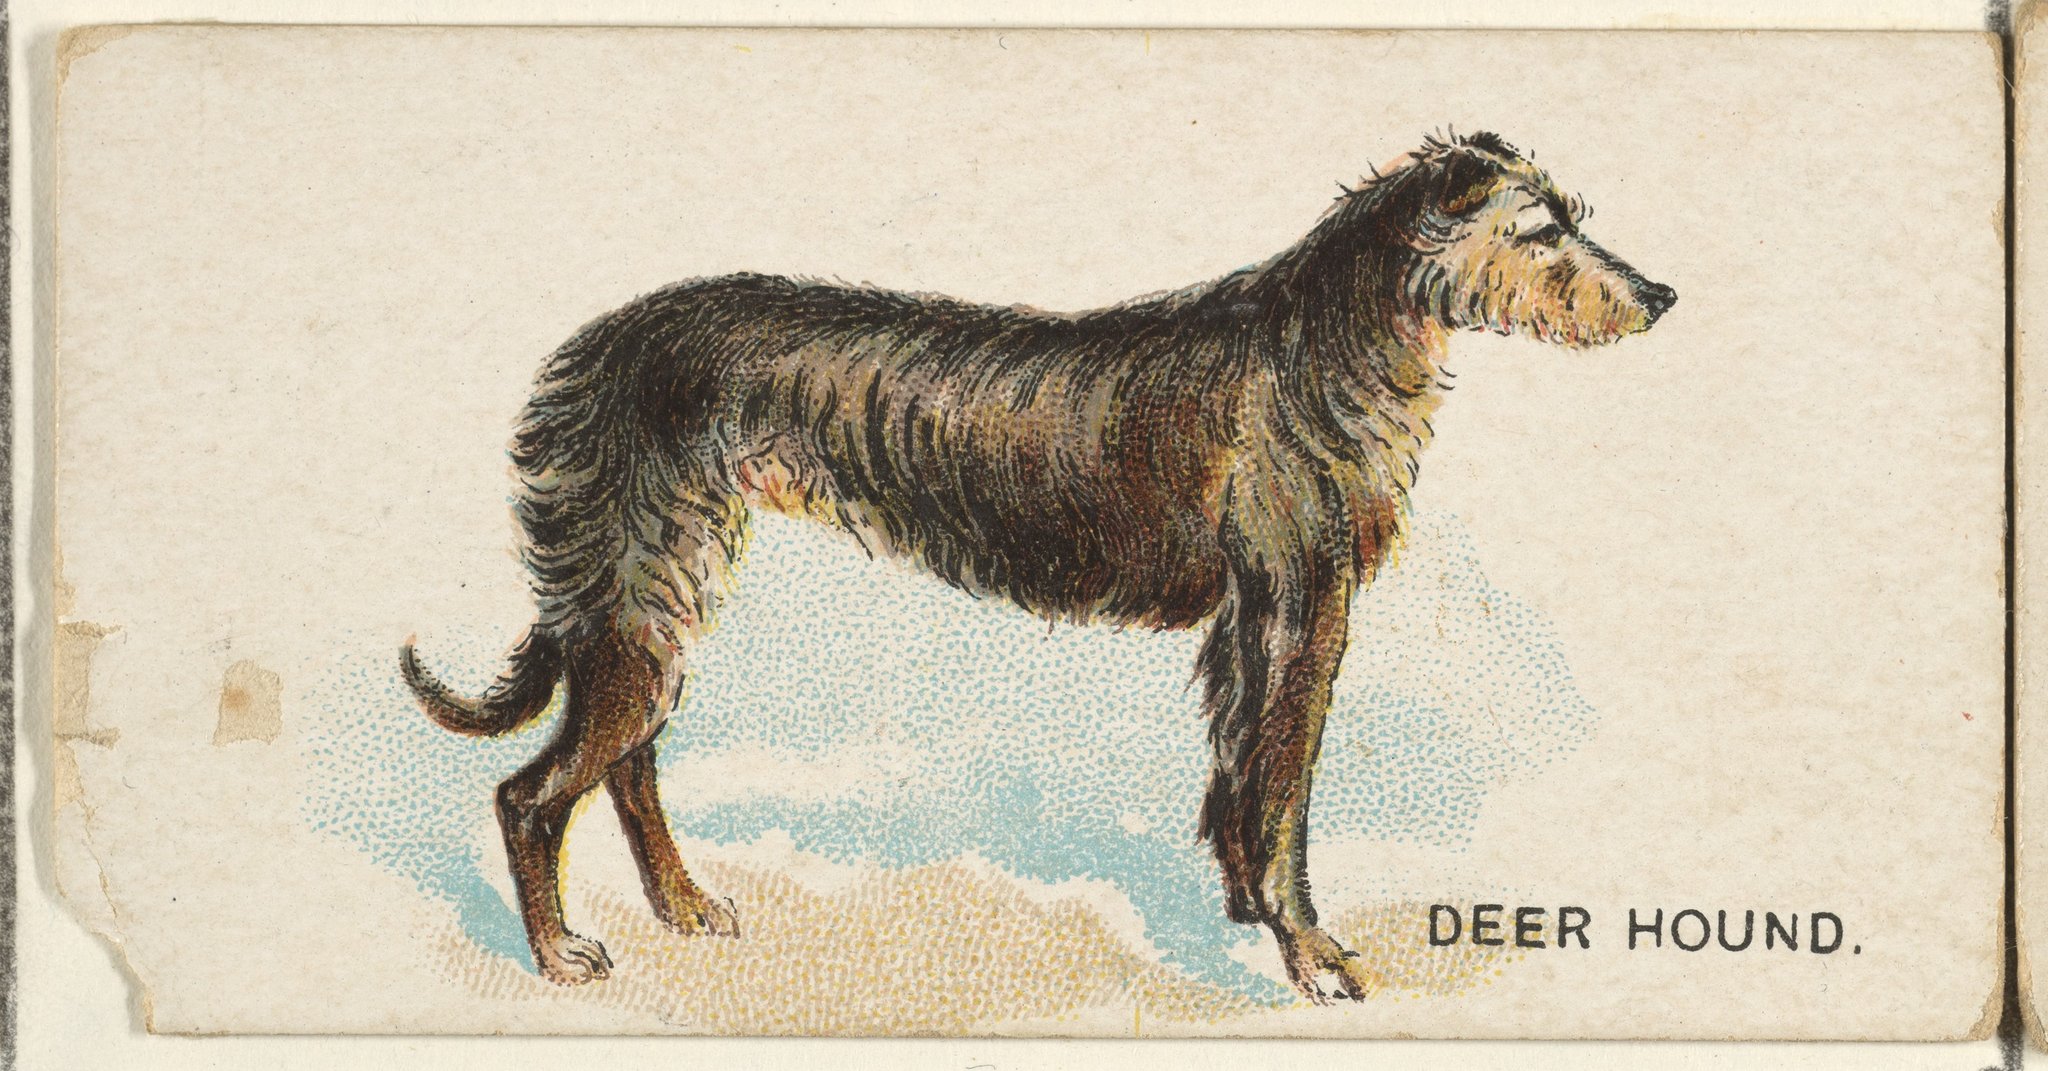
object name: print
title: Deer Hound, from the Dogs of the World series for Old Judge Cigarettes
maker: goodwin & company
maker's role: publisher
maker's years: 1850-1950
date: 1890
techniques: color lithograph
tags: dogs